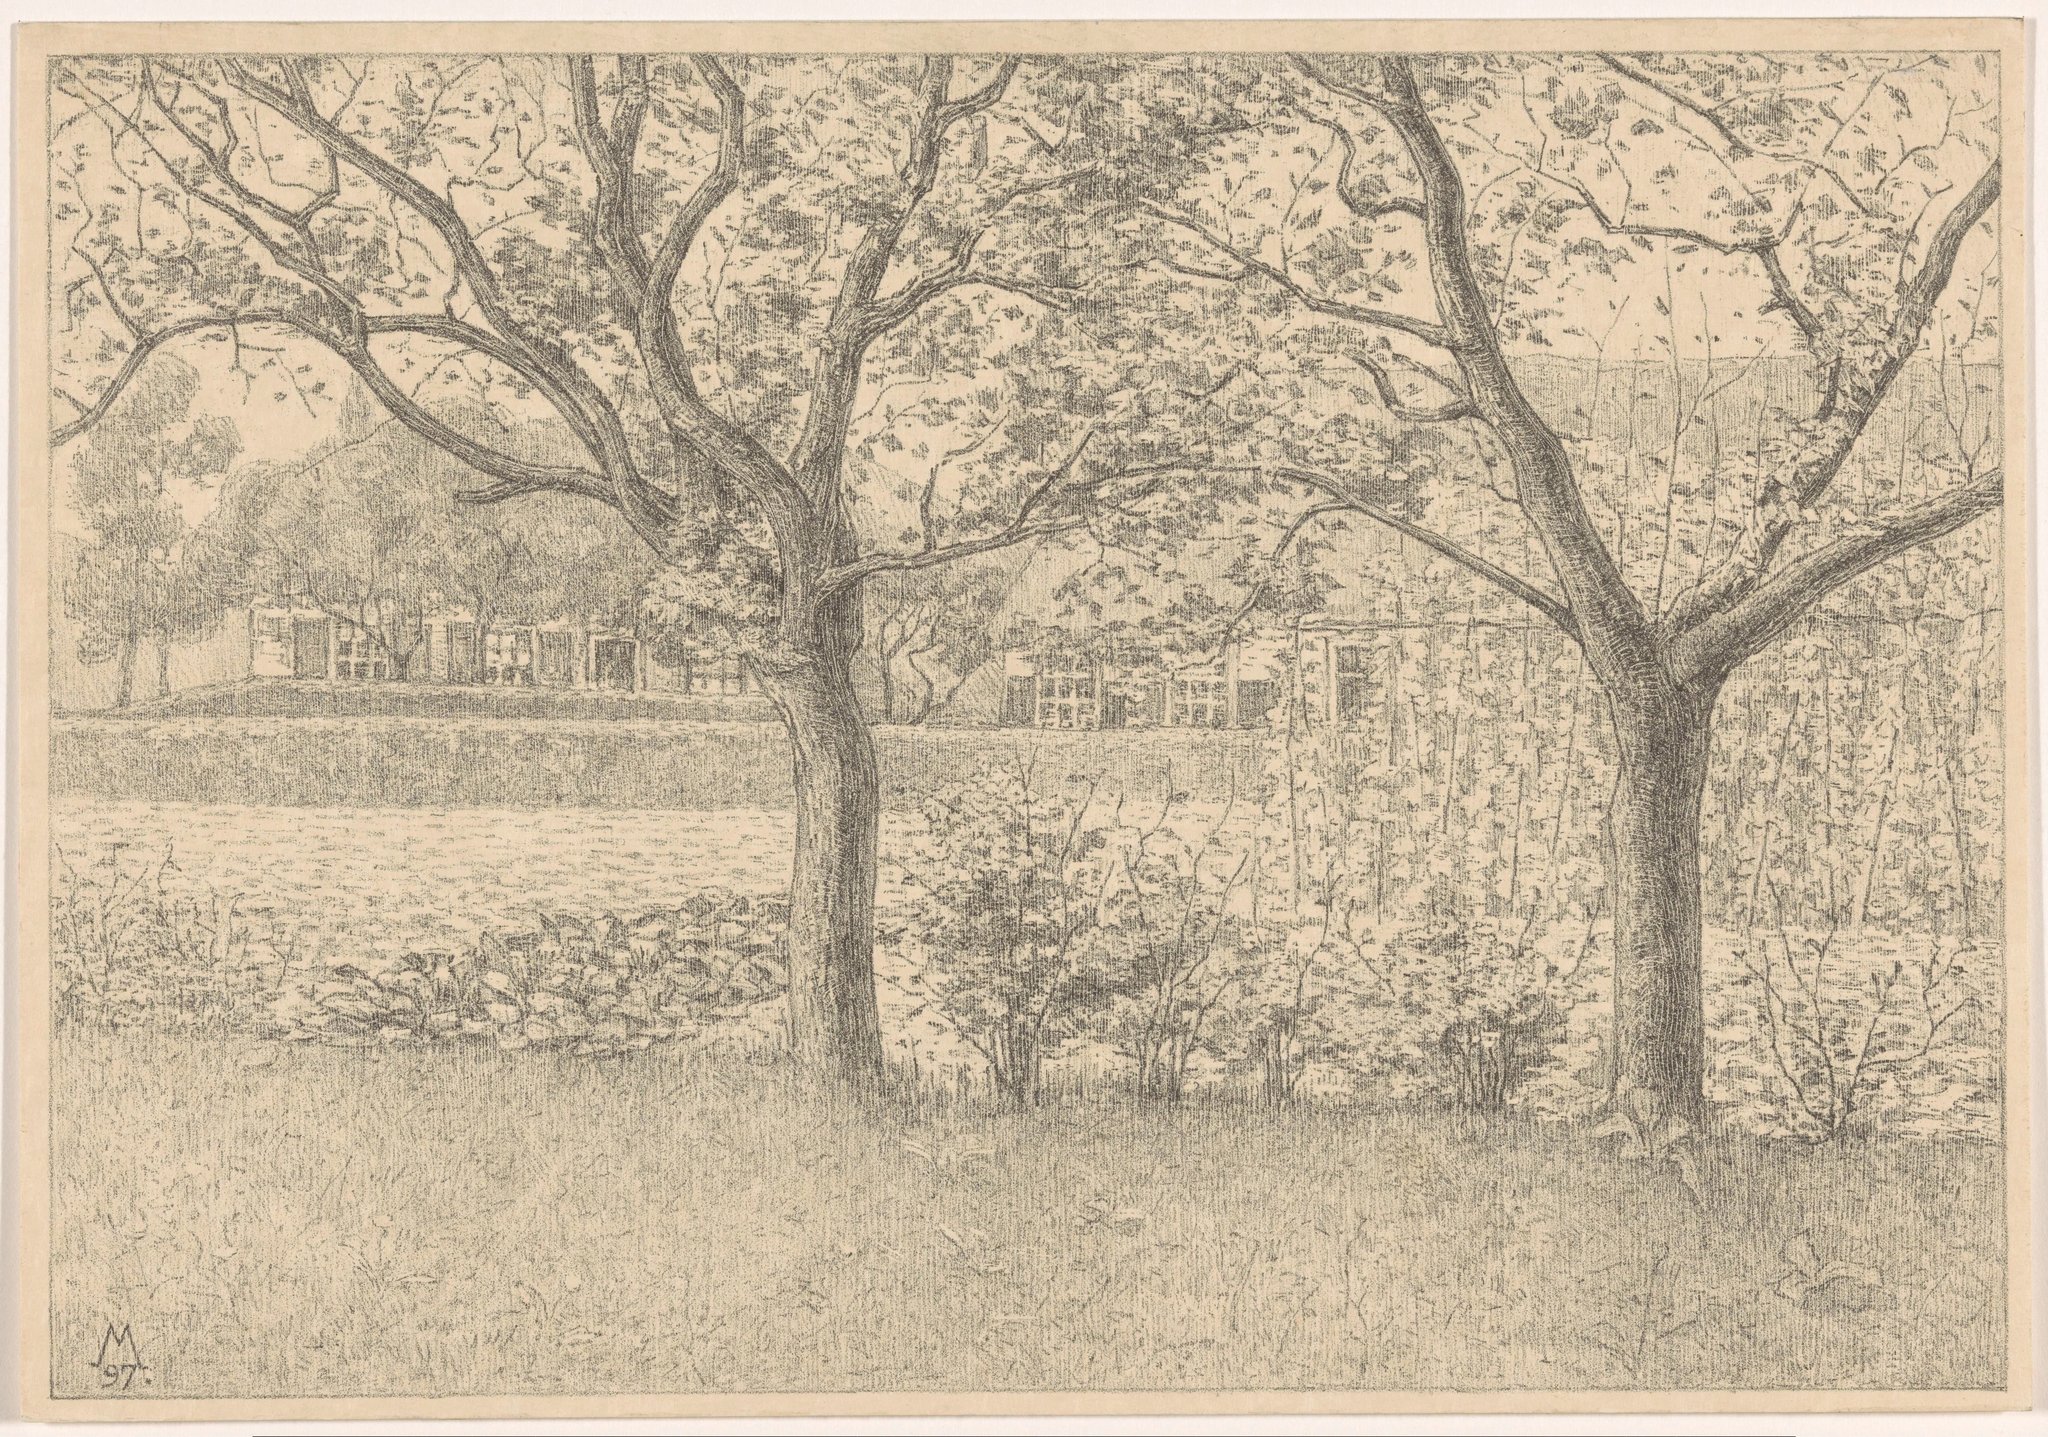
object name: print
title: Tuin in Laren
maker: simon moulijn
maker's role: draughtsman, print maker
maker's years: 1866-1948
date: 1897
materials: cardboard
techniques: lithograph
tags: garden, farm or solitary house in landscape, plants and herbs: bean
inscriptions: collector's mark: Lugt 2228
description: Op de voorgrond twee bomen; erachter een rij stokbonen. Op de achtergrond is een boerderij zichtbaar.